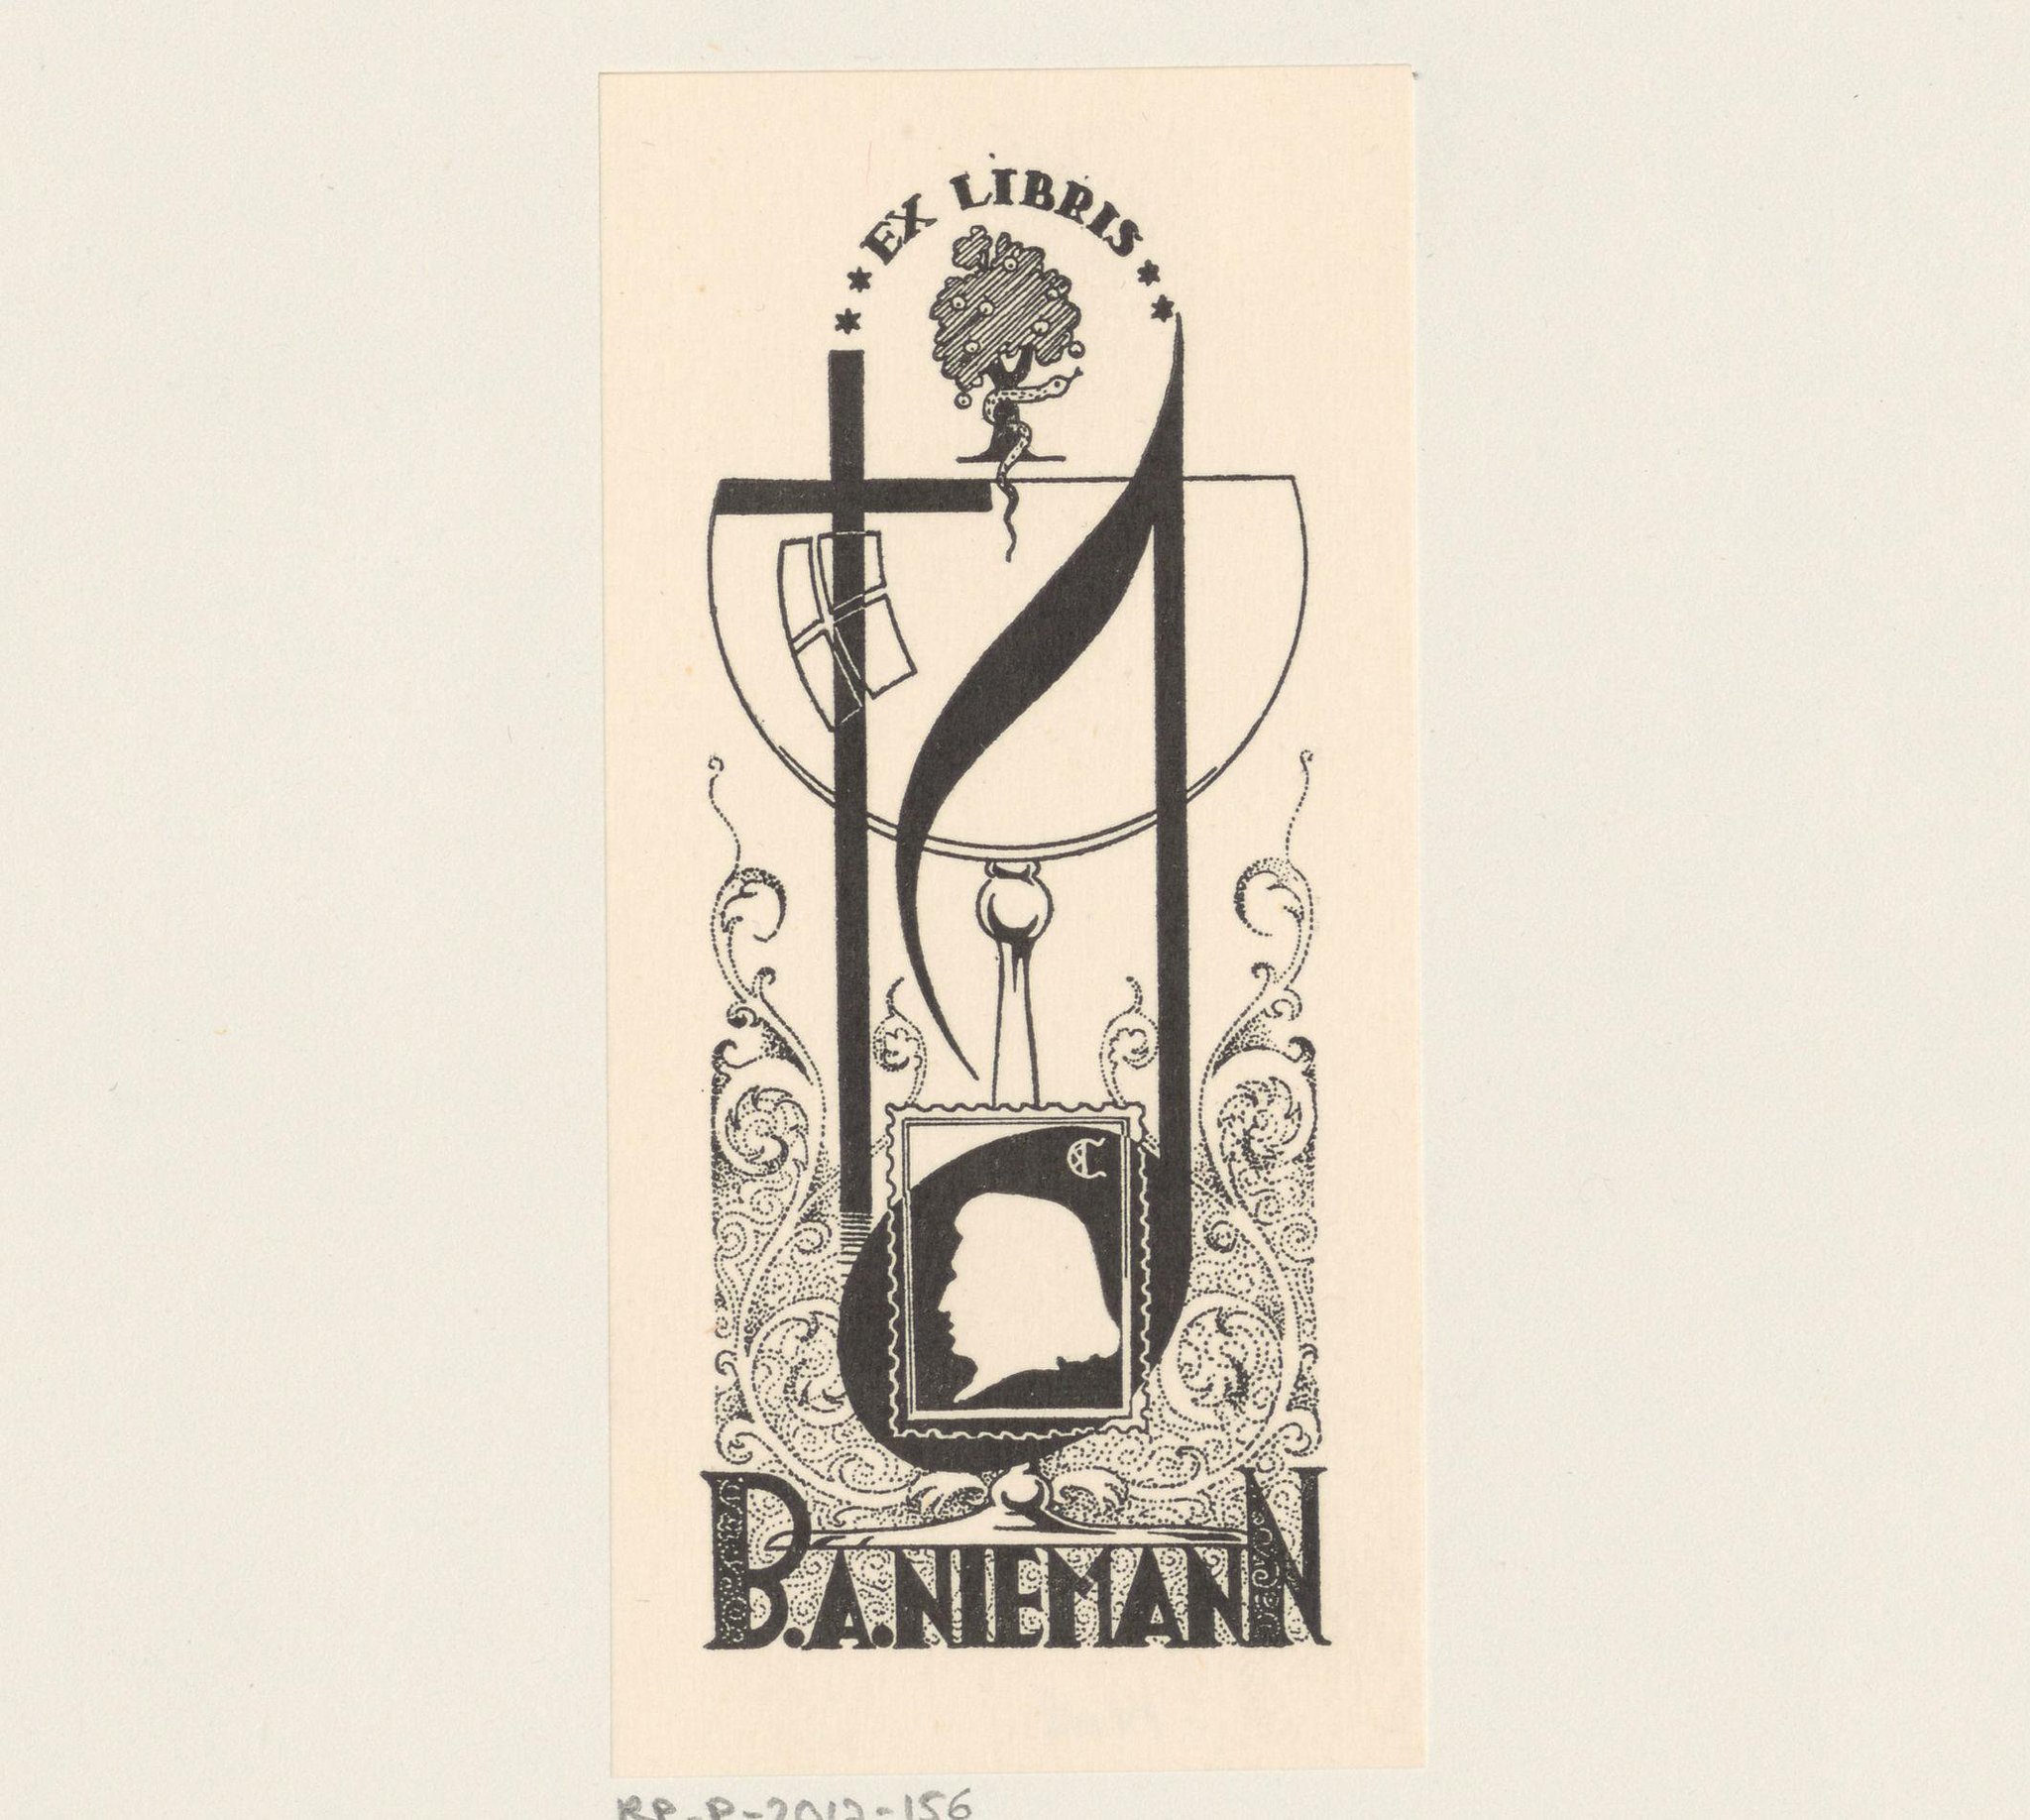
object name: bookplate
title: Ex libris van B.A. Niemann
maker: Anonymous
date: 1850-1950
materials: paper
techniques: printing block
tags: notation of music, stamp (~ postal matter), cross as symbol of christ, face (+ sideview, profile), glass, rummer